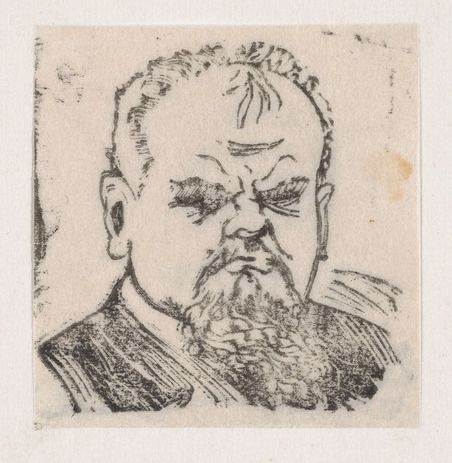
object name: print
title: A man wearing an angry expression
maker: josé guadalupe posada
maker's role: artist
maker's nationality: mexican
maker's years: 1852-1913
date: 1880-1910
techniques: woodcut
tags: anger,men